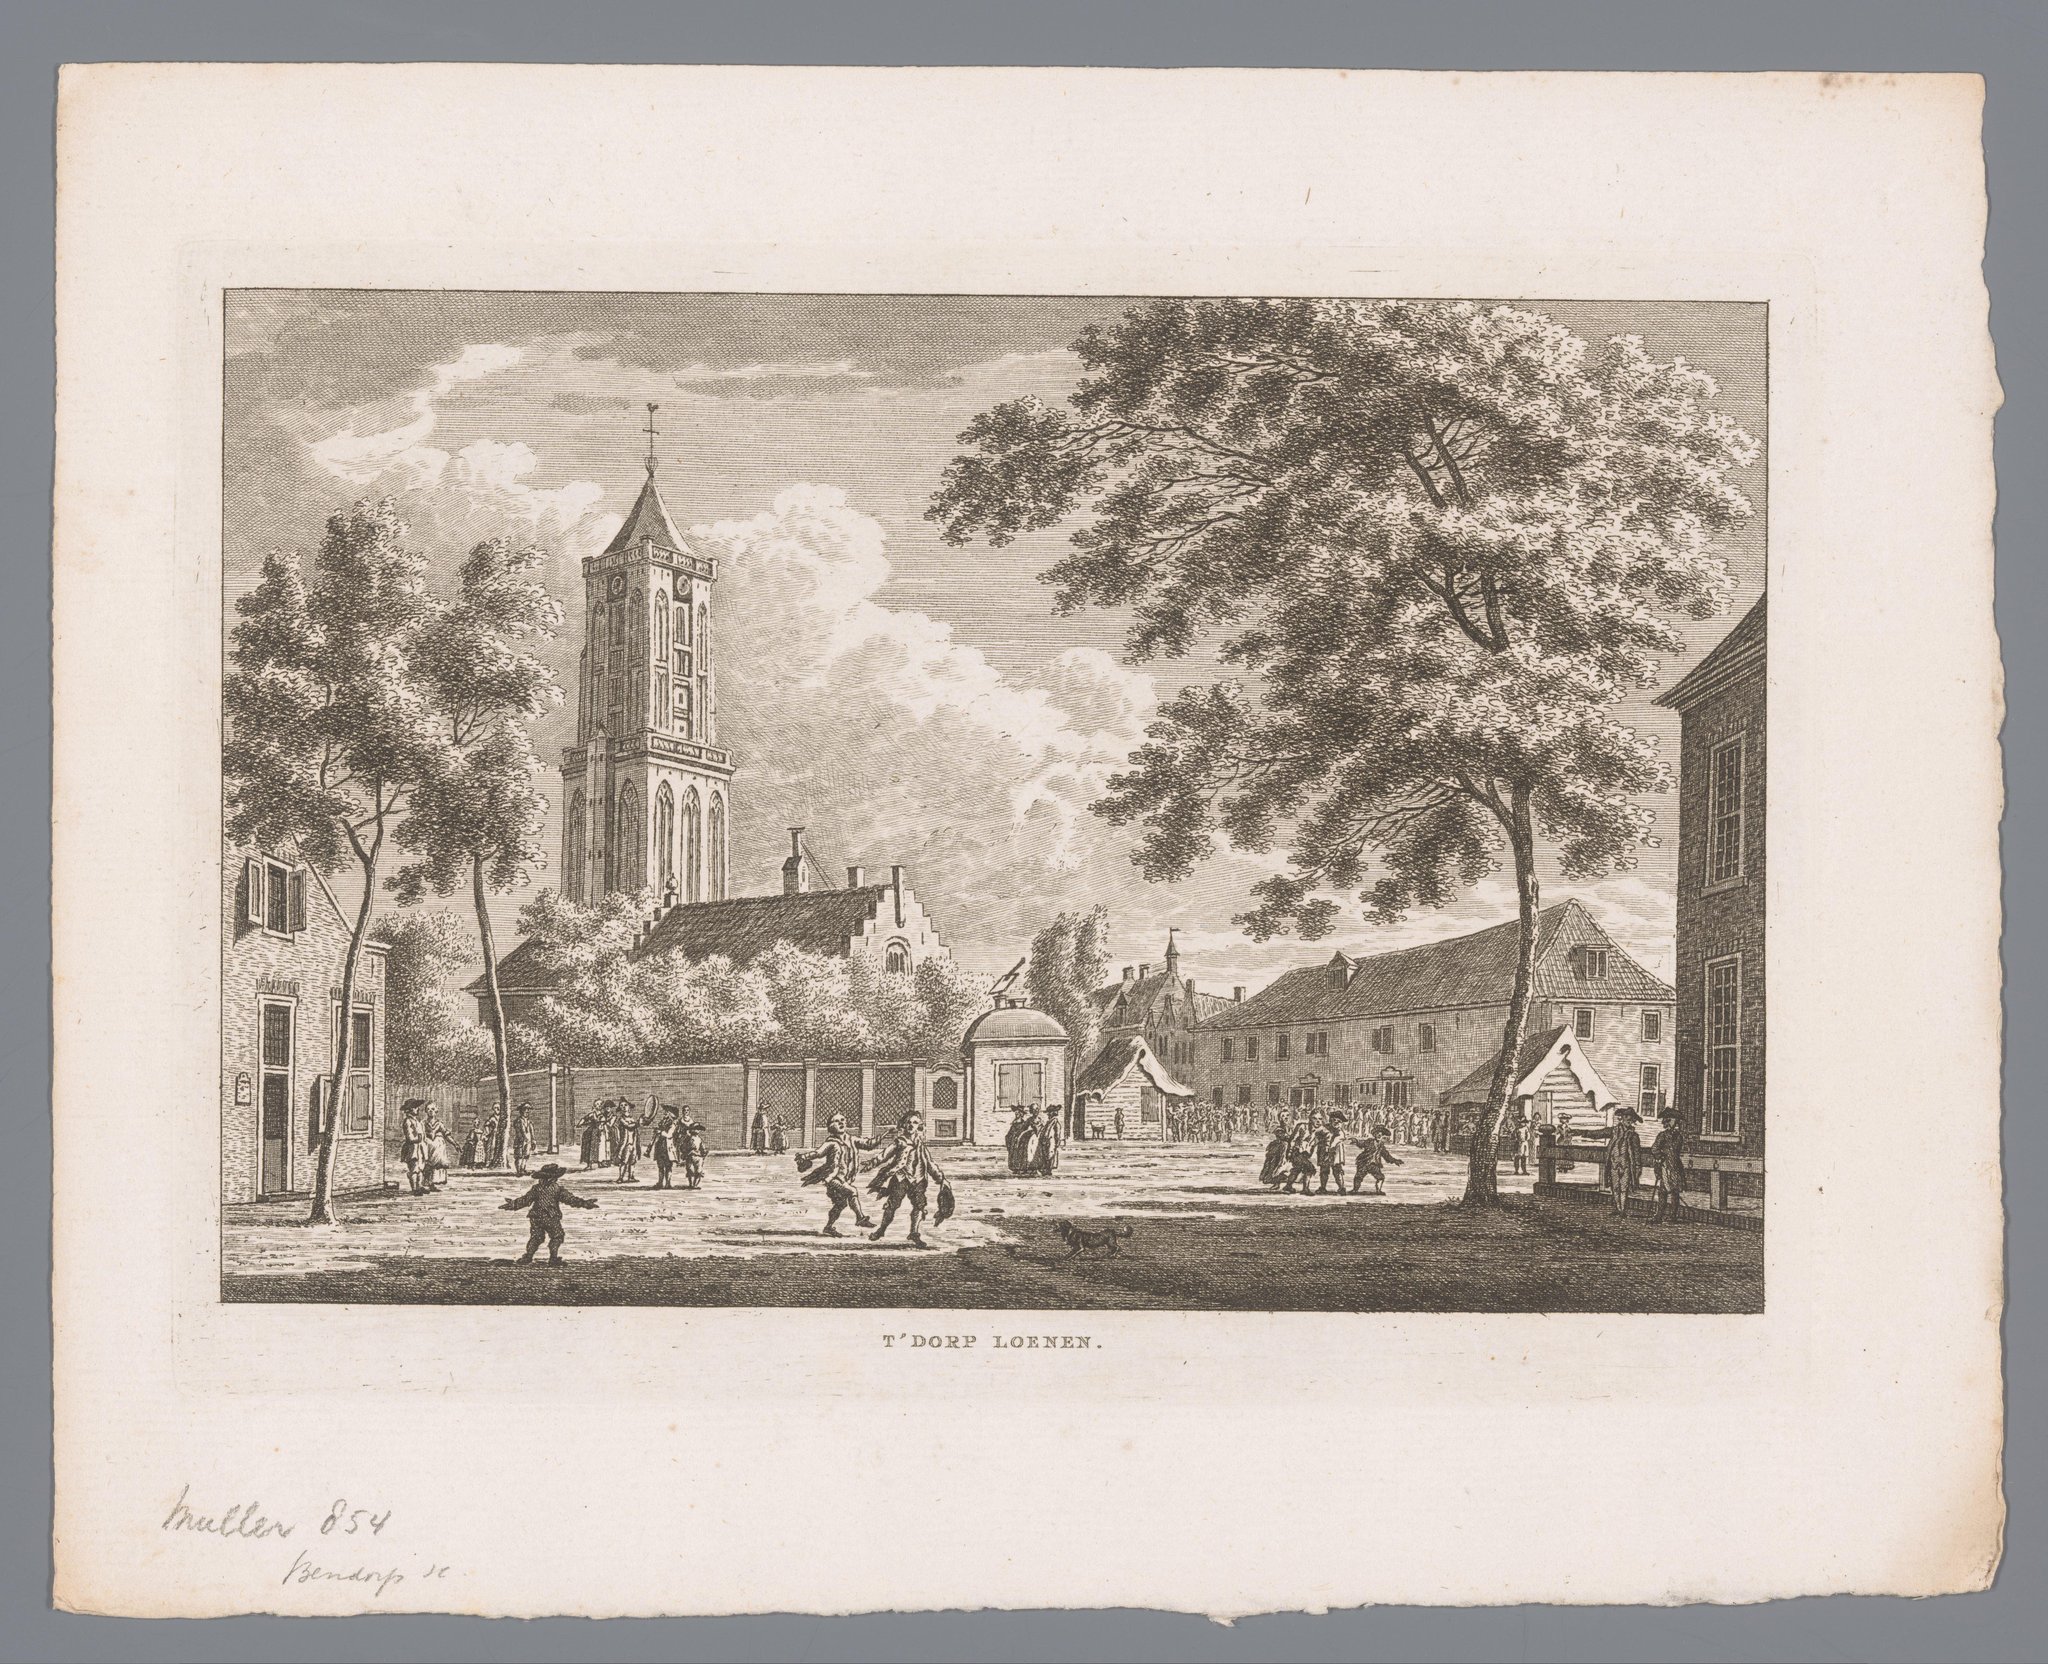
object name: print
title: T' Dorp Loenen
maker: carel frederik bendorp (i)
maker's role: print maker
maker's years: 1736-1814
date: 1786-1792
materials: paper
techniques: etching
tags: city-view, and landscape with man-made constructions, church (exterior), village square, place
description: Prent uit: Vaderlandsche gezichten, of afbeeldingen van den tegenwoordigen staat der Vereenigde Nederlanden (…). Amsterdam: Hendrik Gartman, Willem Vermandel en Jan Willem Smit, 1786-1792. Uitgegeven in afleveringen met ieder een eigen bifolium en inhoudsopgave. Alle prenten in deze publicatie zijn gegraveerd door Carel Frederik Bendorp (I) en, in de meeste gevallen, gebaseerd op tekeningen van Jan Bulthuis.